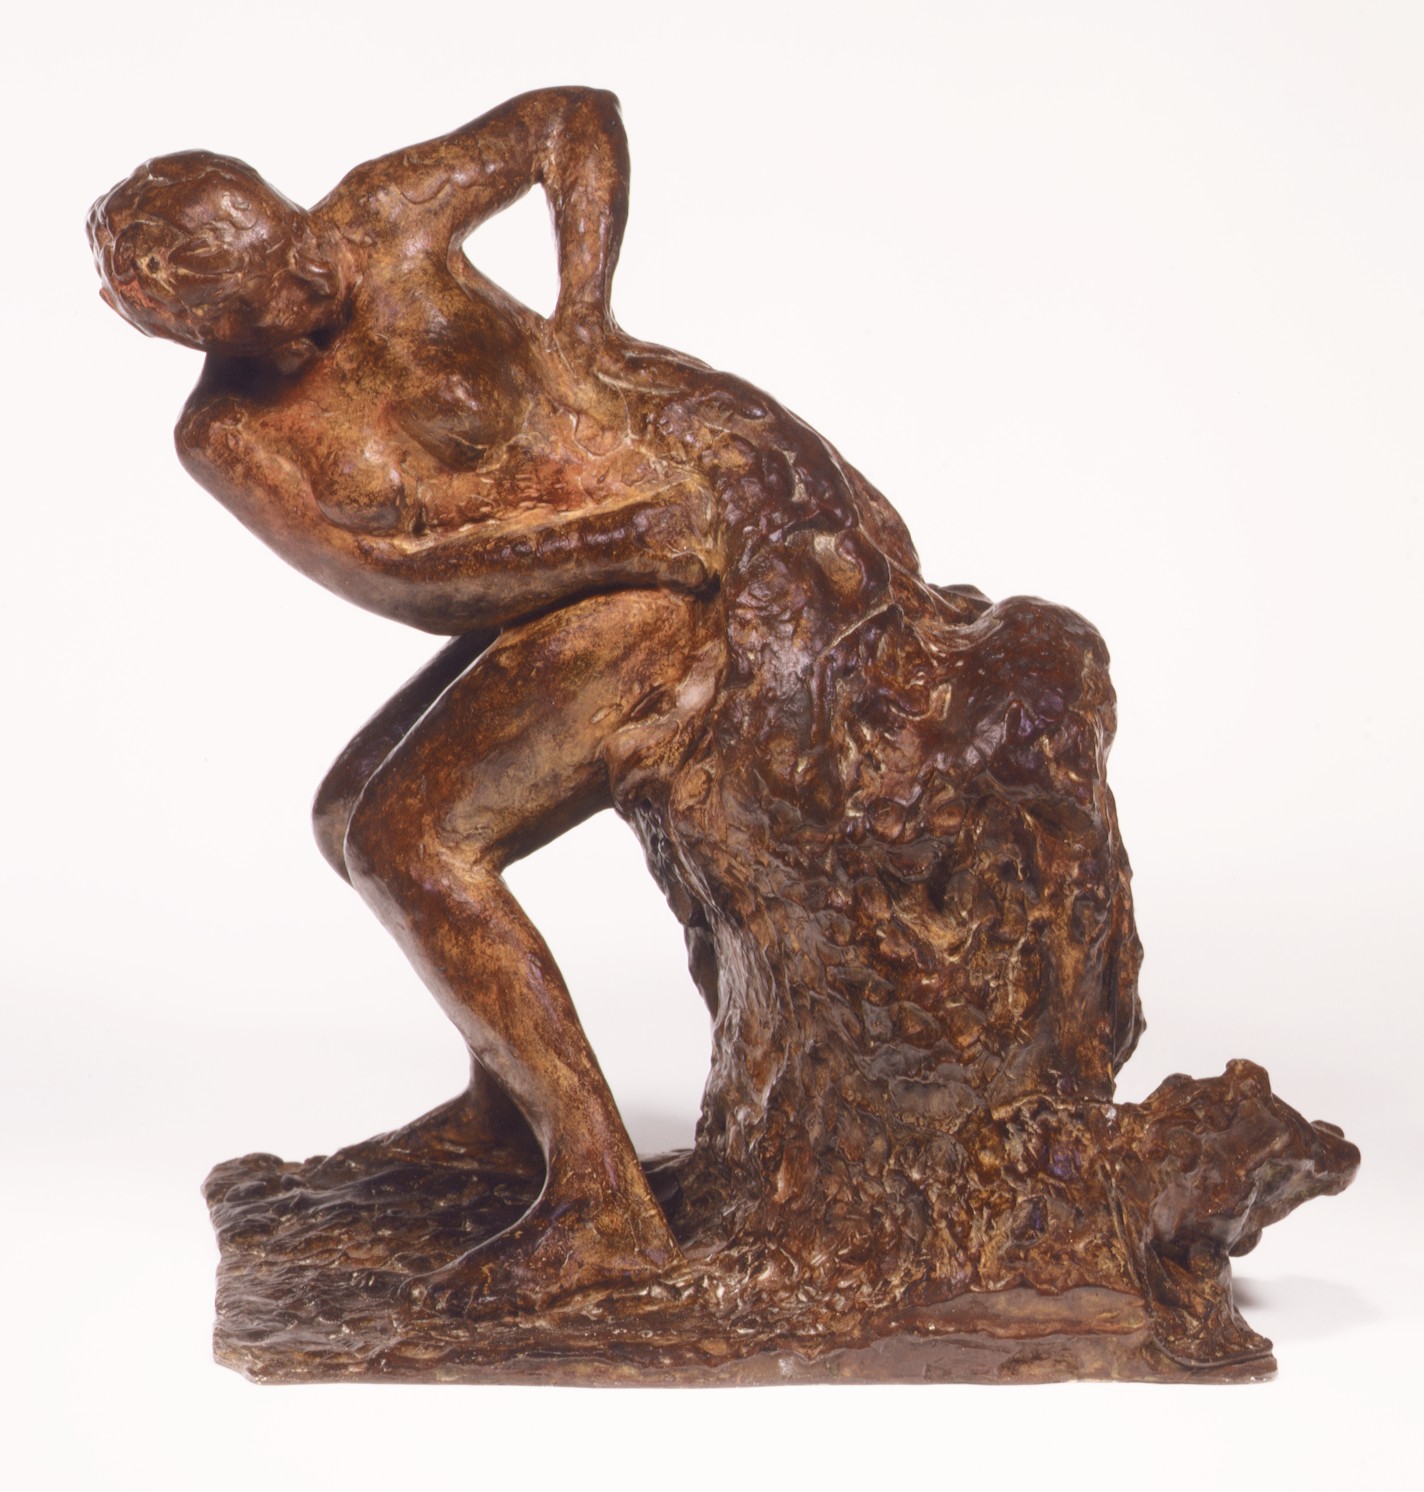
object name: statuette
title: Woman Seated in Chair Wiping her Left Side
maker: edgar degas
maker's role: artist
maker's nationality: french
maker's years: 1834-1917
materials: bronze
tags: female nudes